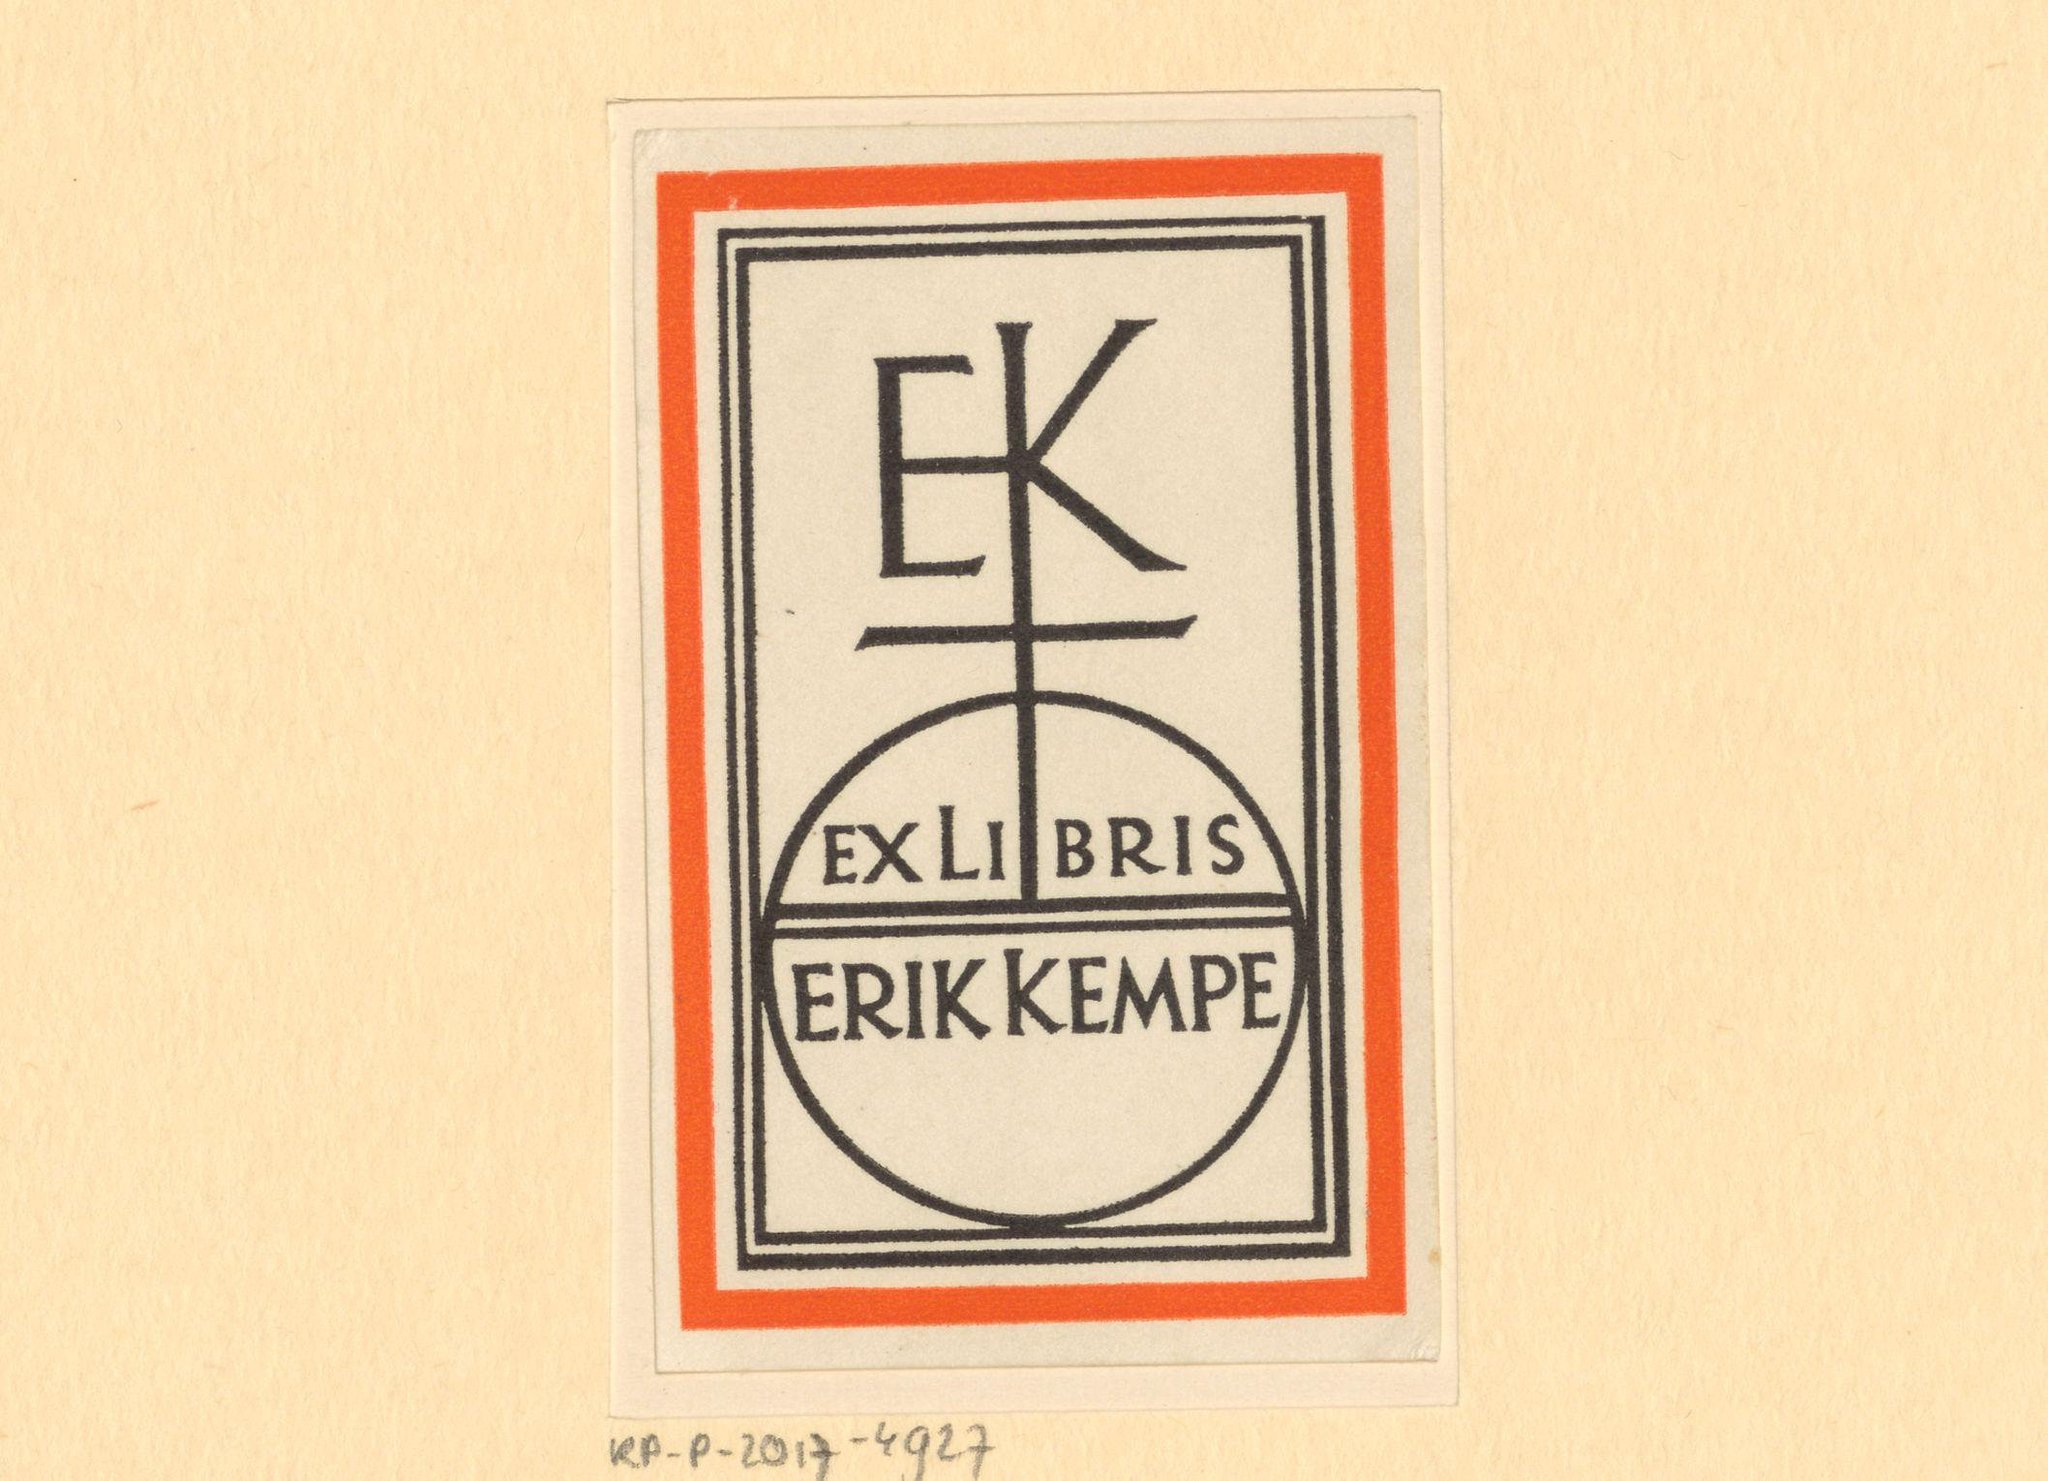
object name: bookplate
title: Ex libris van Erik Kempe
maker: Anonymous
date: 1940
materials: paper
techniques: printing block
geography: germany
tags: the cross ~ symbols of christ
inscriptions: inscription: ‘Hugo Steiner-Prag, cl. ±1940’